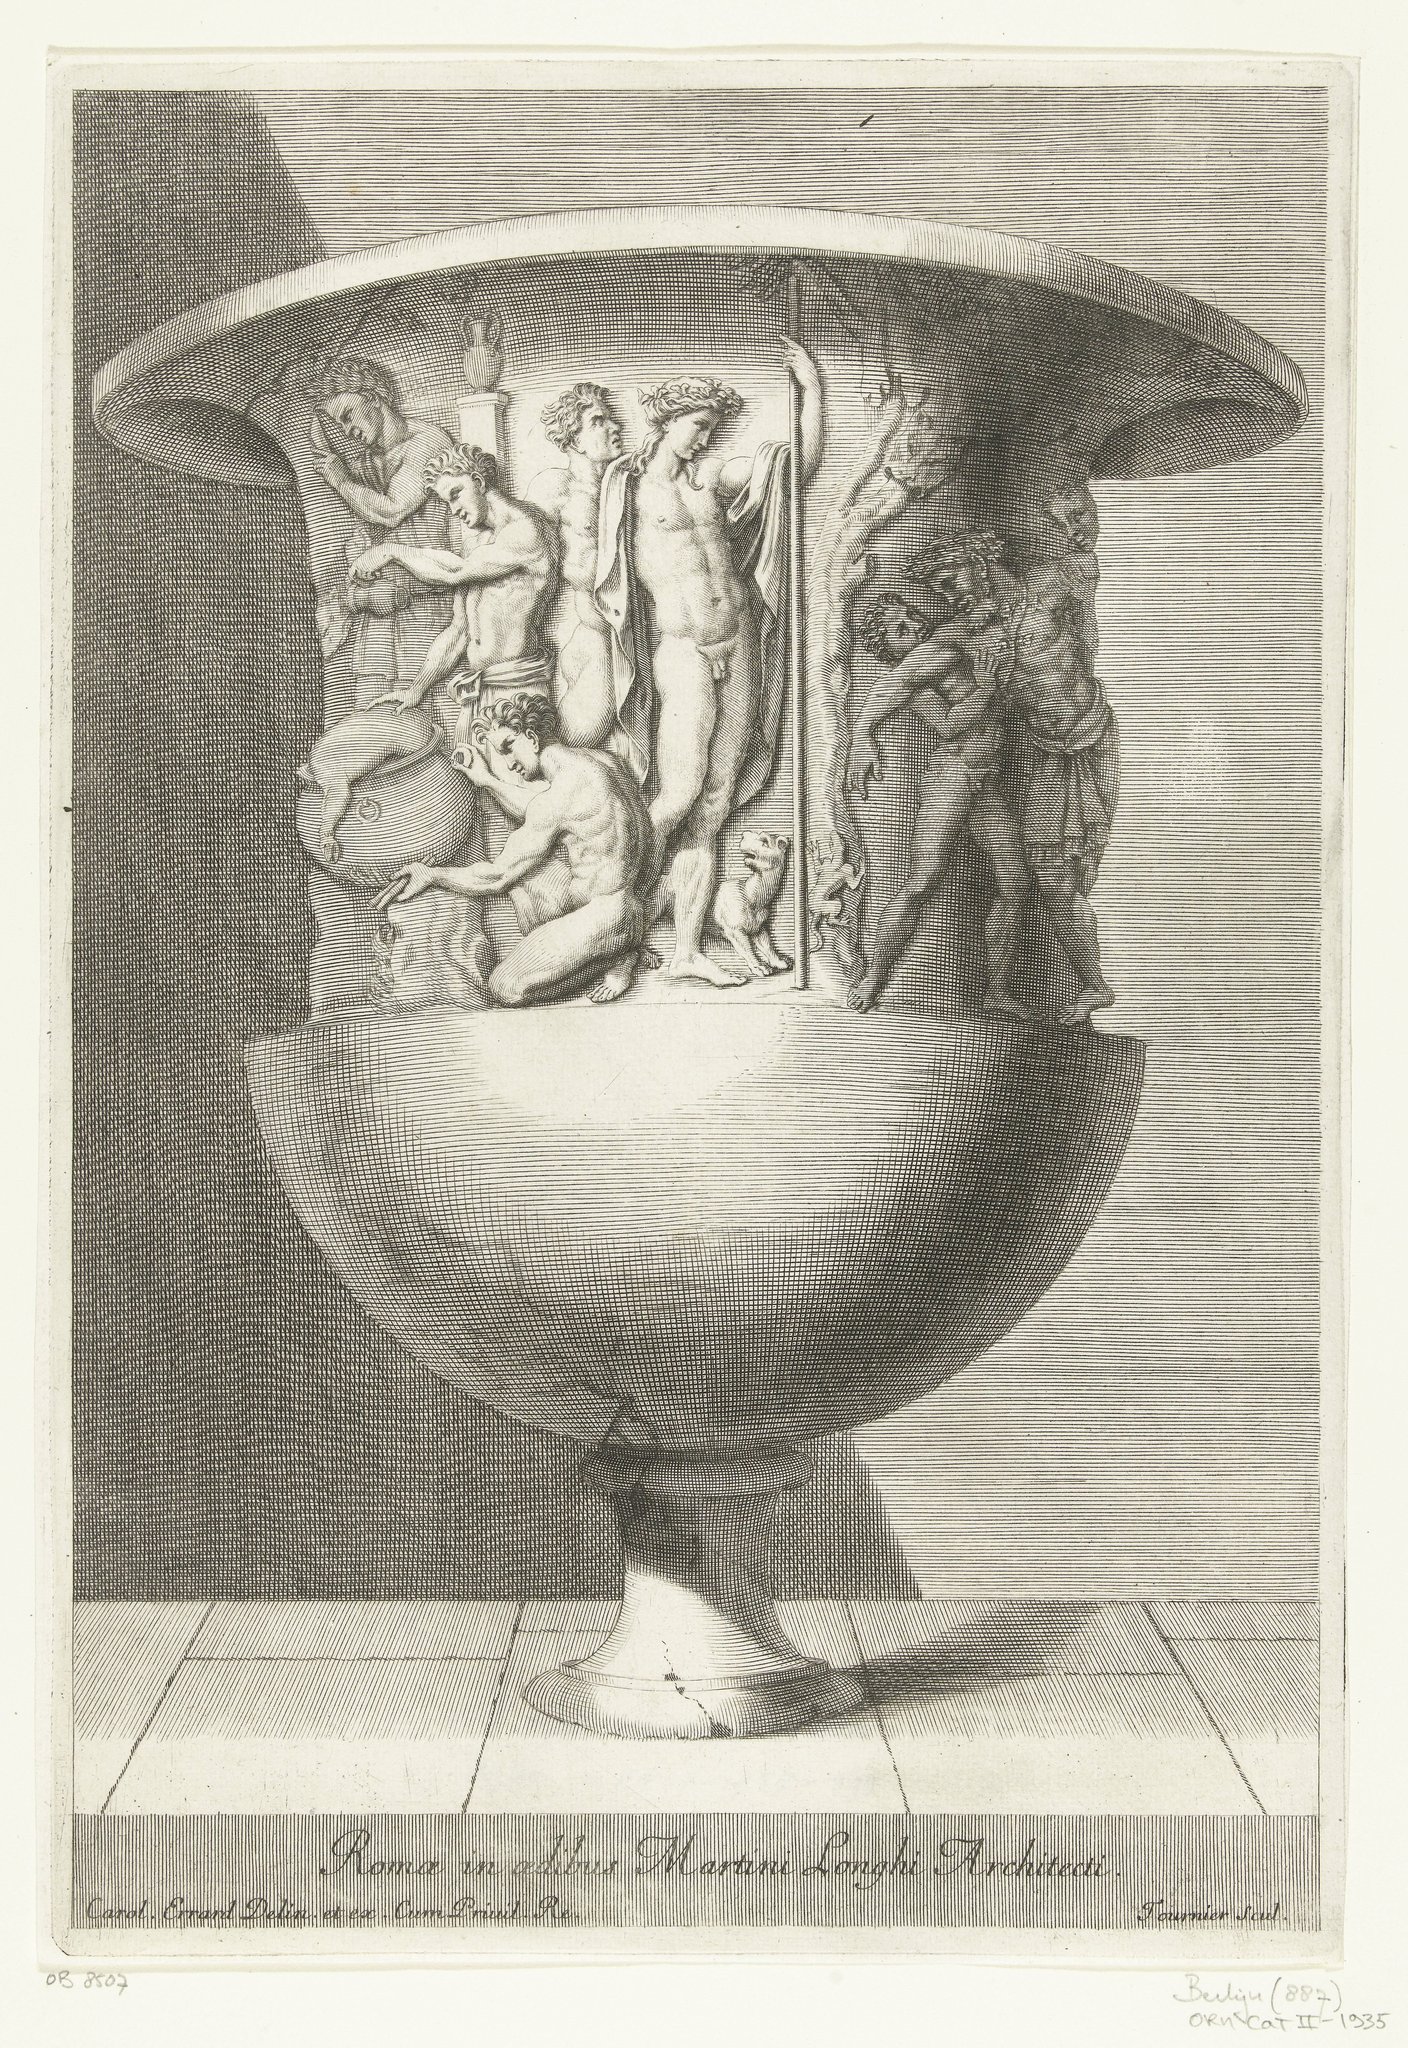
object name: ornament print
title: Recueil de divers vases antiques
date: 1650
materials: paper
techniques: engraving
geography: france